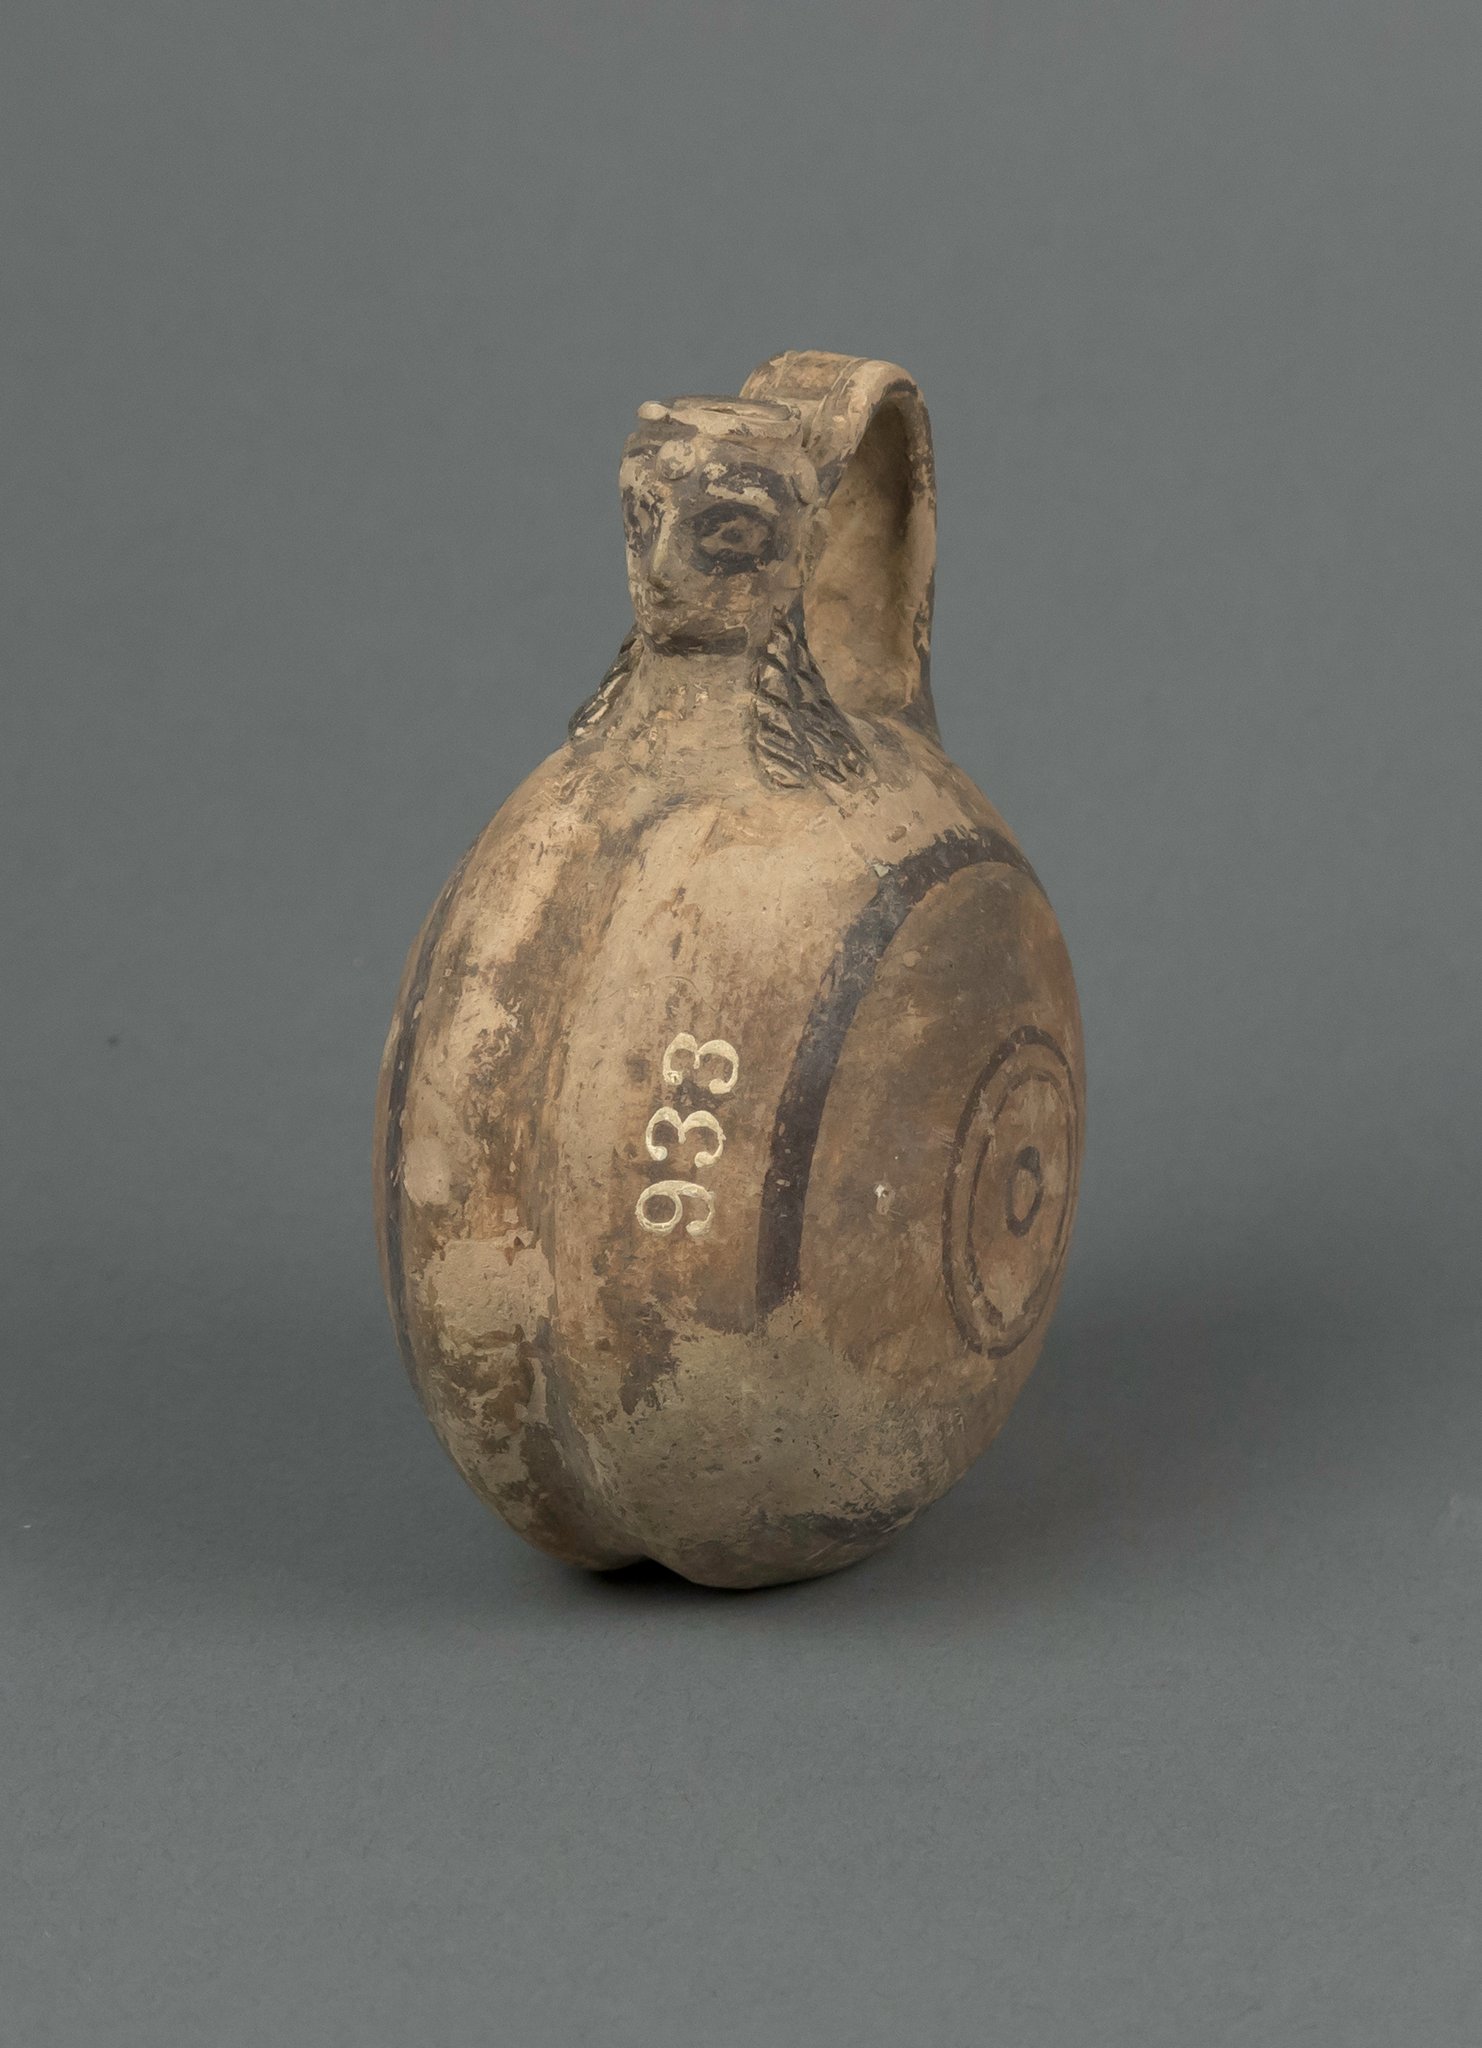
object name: jug with female head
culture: cypriot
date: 750-600 BCE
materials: terracotta